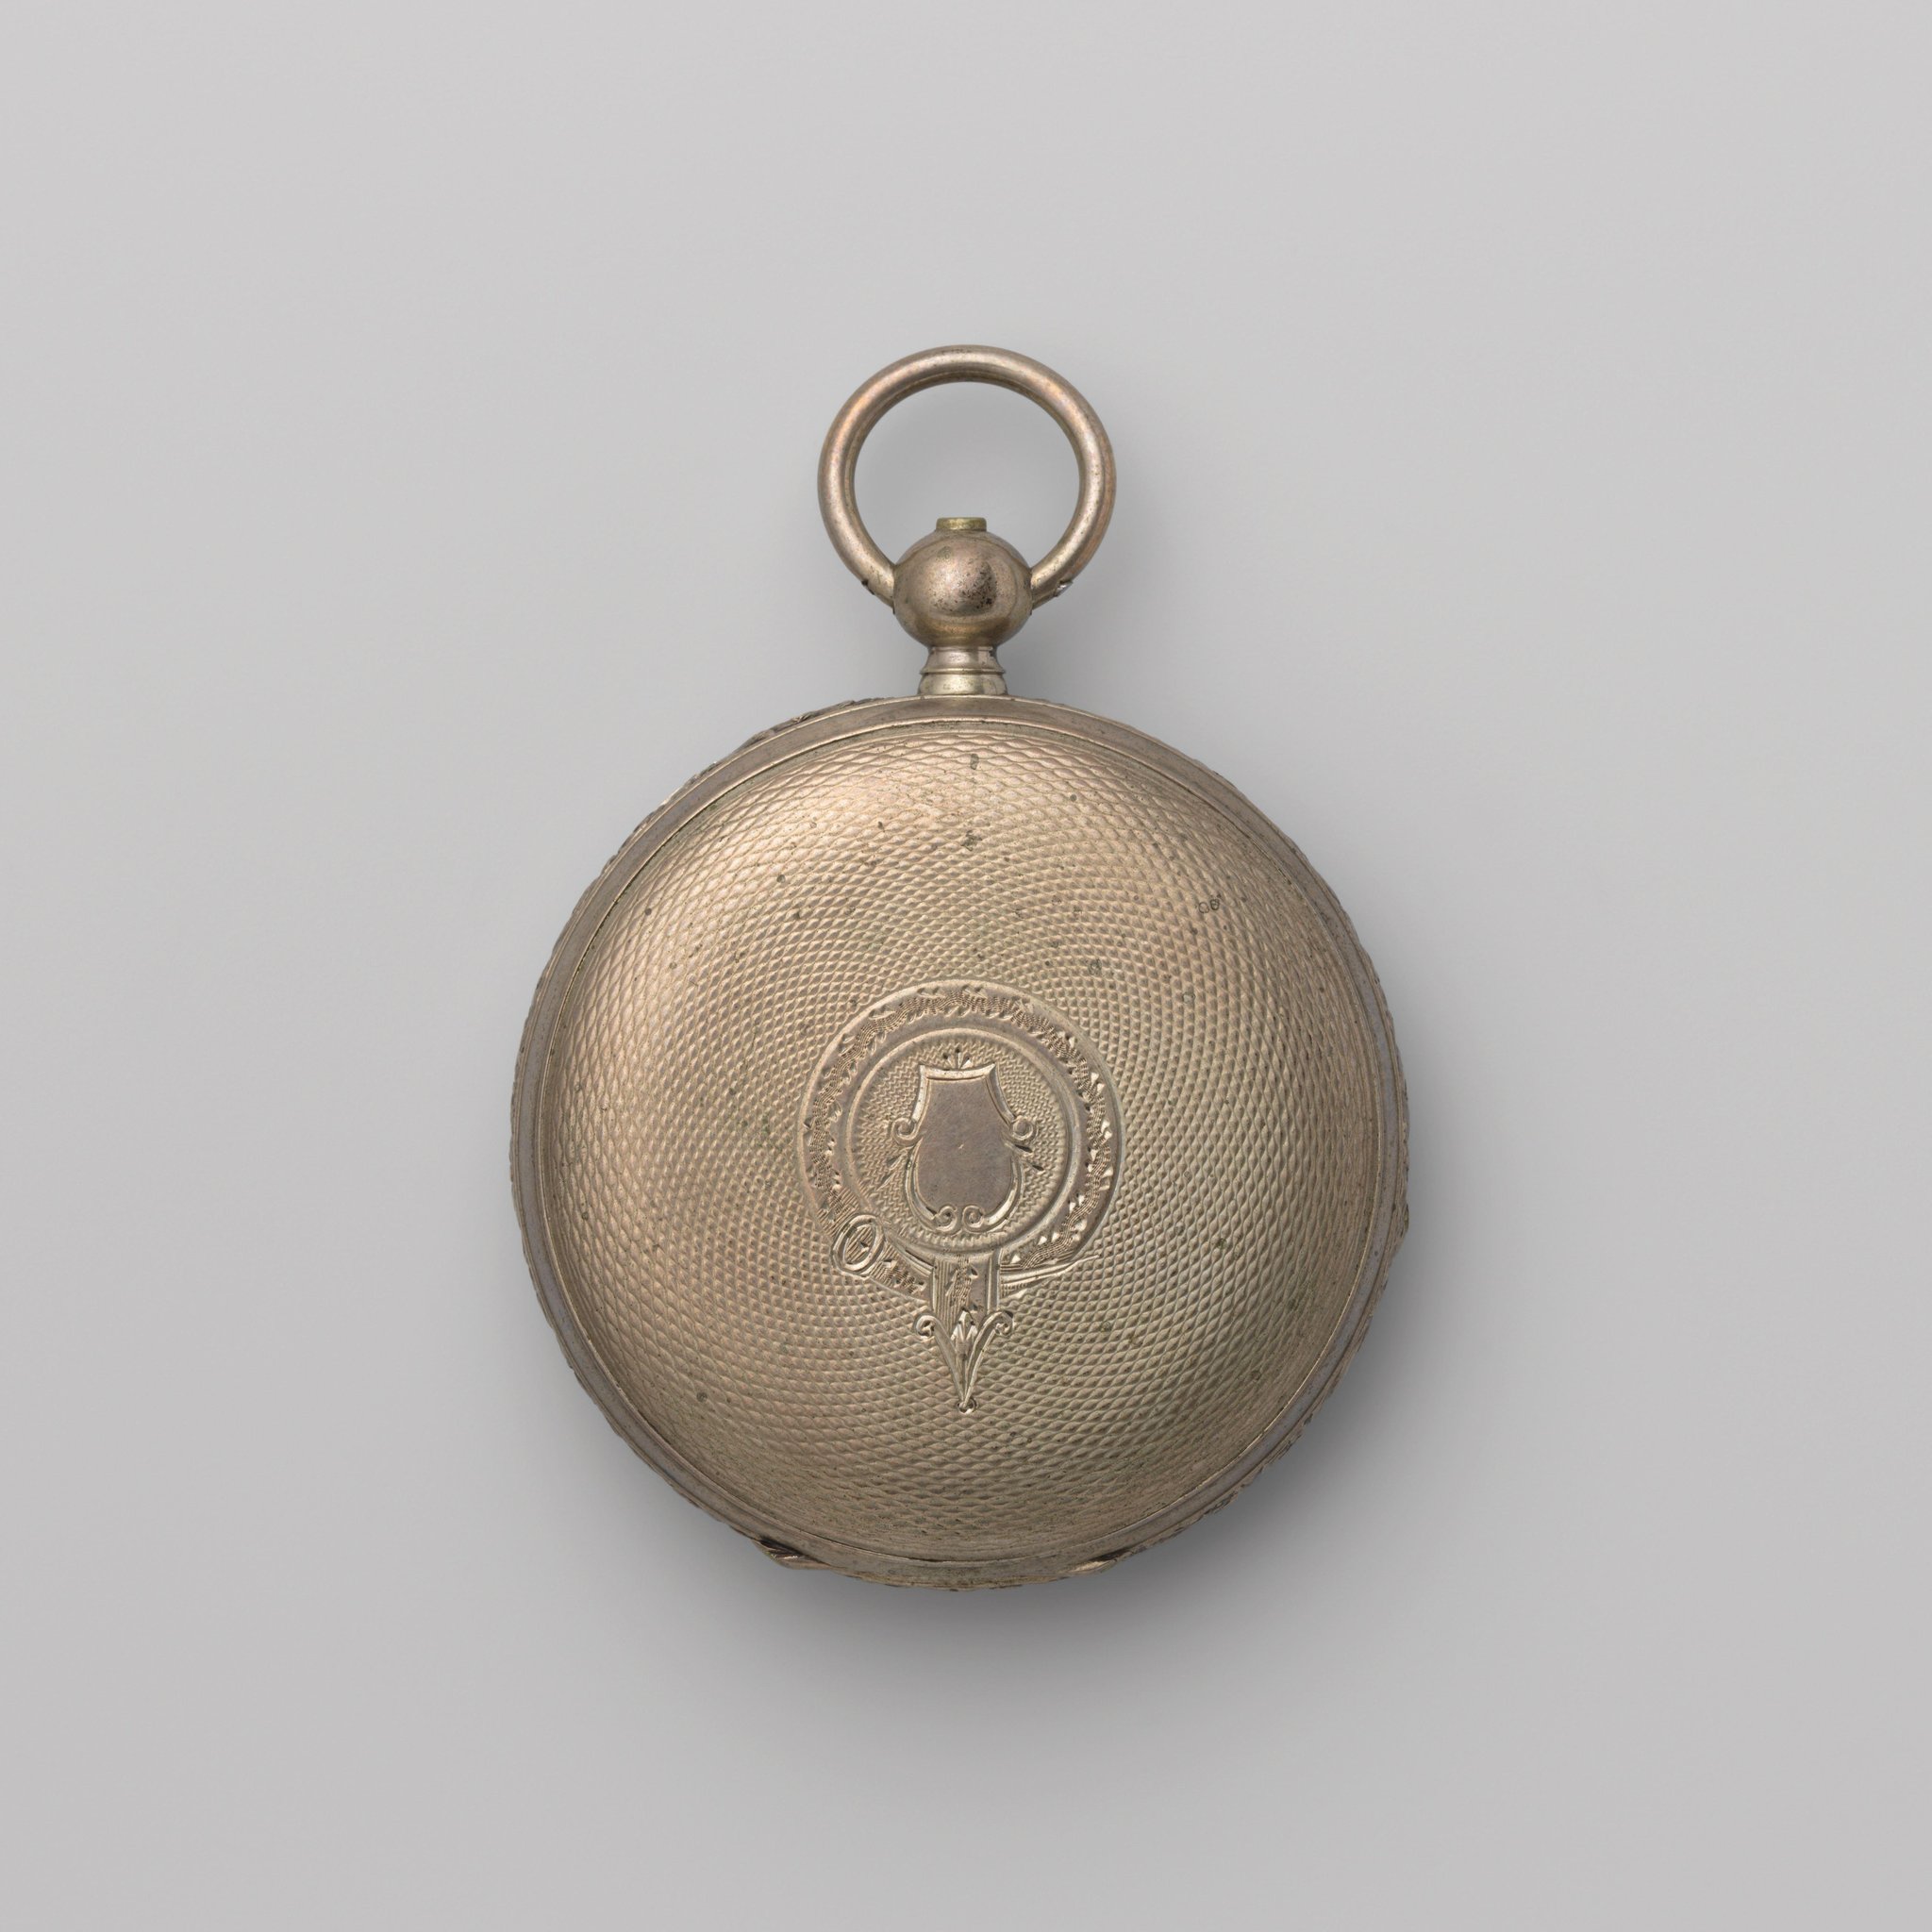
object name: jewellery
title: Horloge van zilver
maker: Anonymous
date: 1870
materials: silver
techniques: engine turning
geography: switzerland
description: Horloge van zilver, met duplexgang en witgeëmailleerde wijzerplaat. De achter- en voorbodem zijn geguillocheerd.